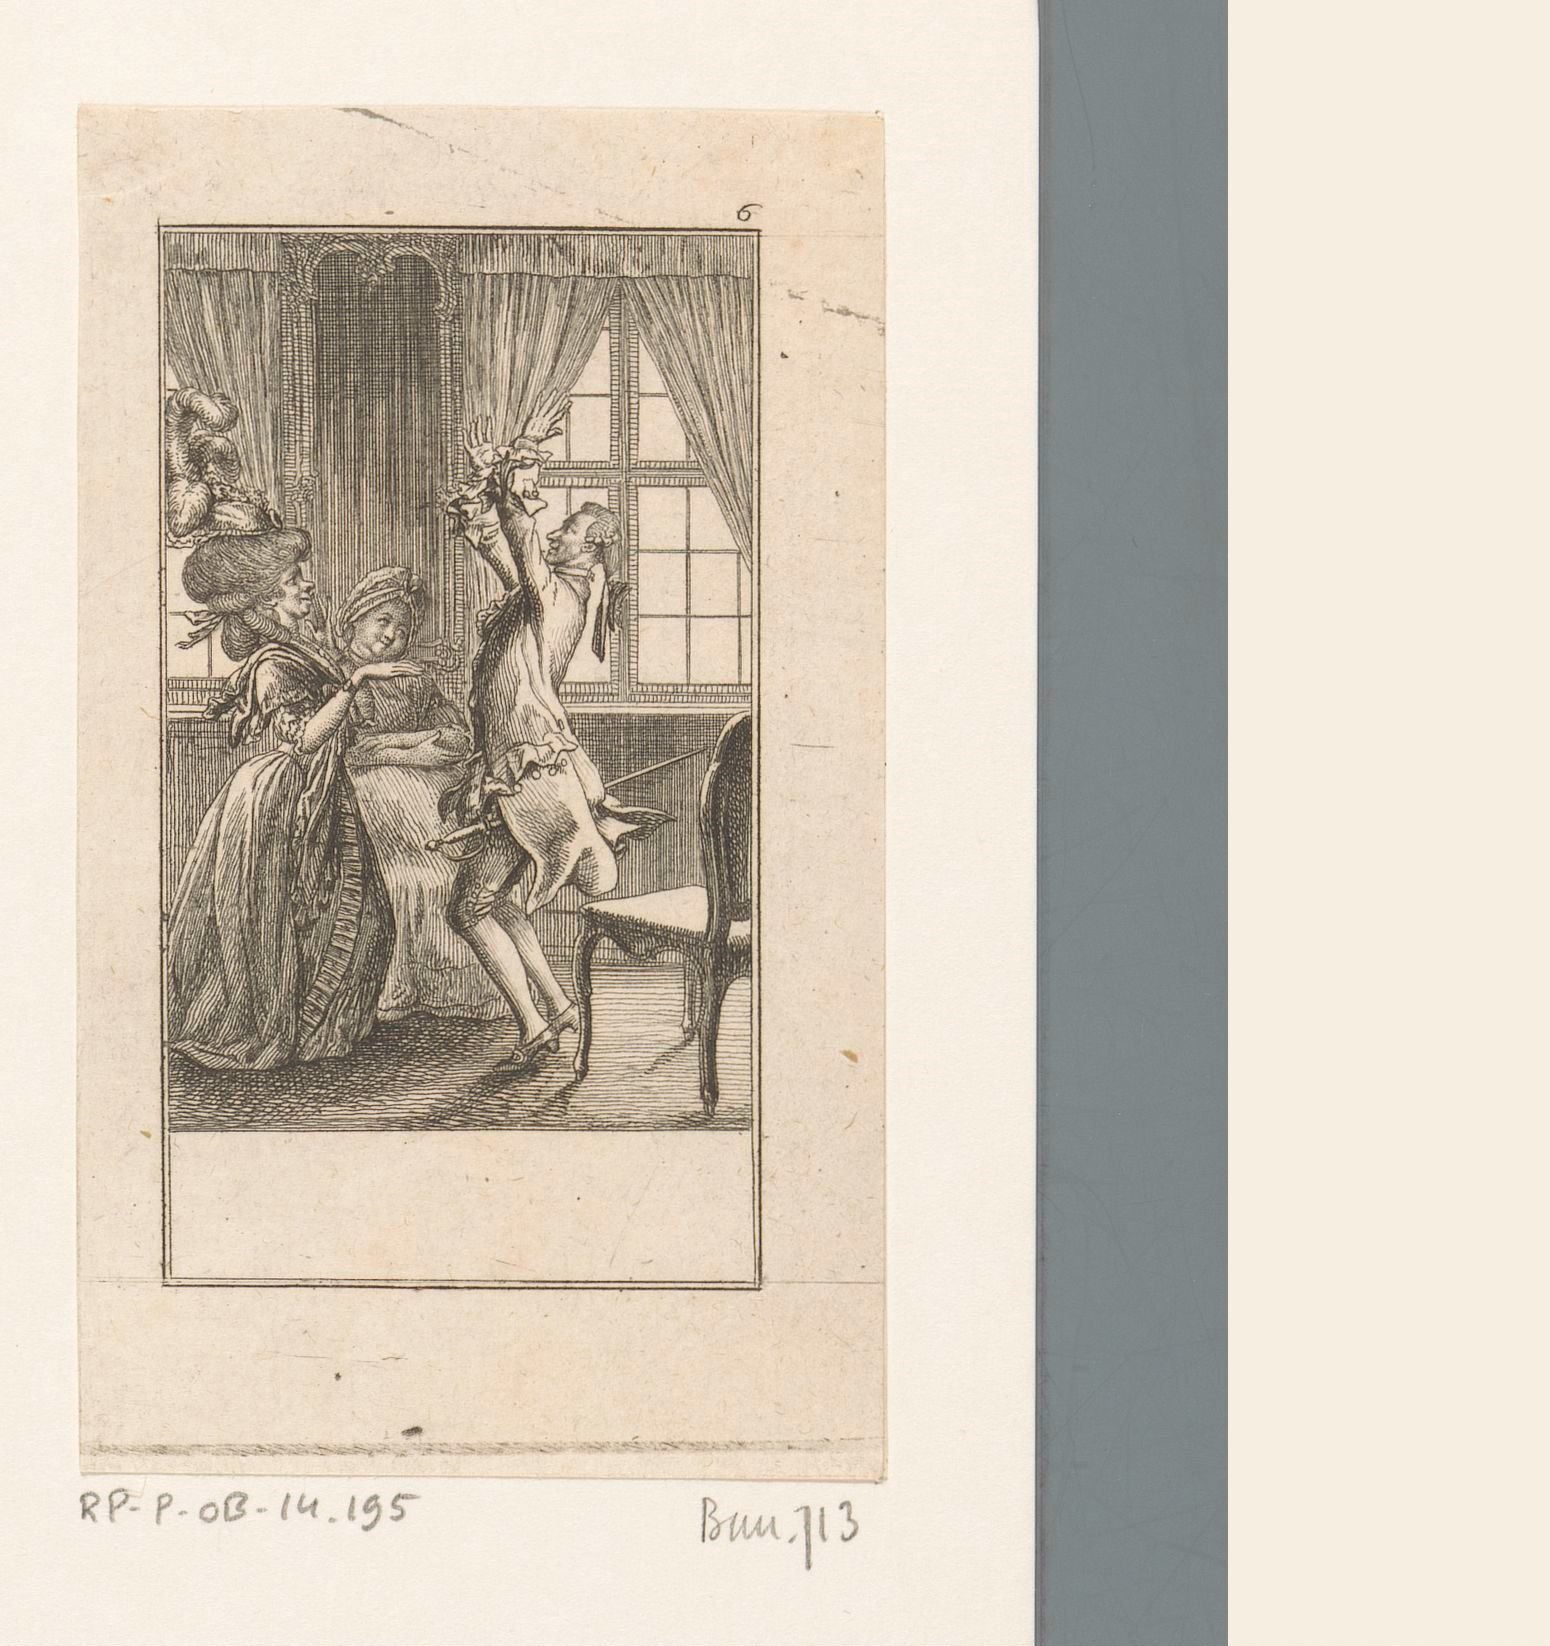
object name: print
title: Huwelijksaanzoek van een dichter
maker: daniel nikolaus chodowiecki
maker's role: draughtsman, print maker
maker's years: 1726-1801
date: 1780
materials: paper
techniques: etching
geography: berlin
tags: writer, poet, author, proposal, declaration of love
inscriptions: collector's mark: Lugt 2228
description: Zesde prent afkomstig uit een serie van twaalf huwelijksaanzoeken (eerste serie). De scènes zijn op een plaat geëtst. Een latere staat van deze serie is ook gebruikt in: Almanac de Goettingue pour l'année 1781. Mit Erklärung der 12 Blätter von Georg Christoph Lichtenberg. Göttingen: Johann Christian Dieterich.